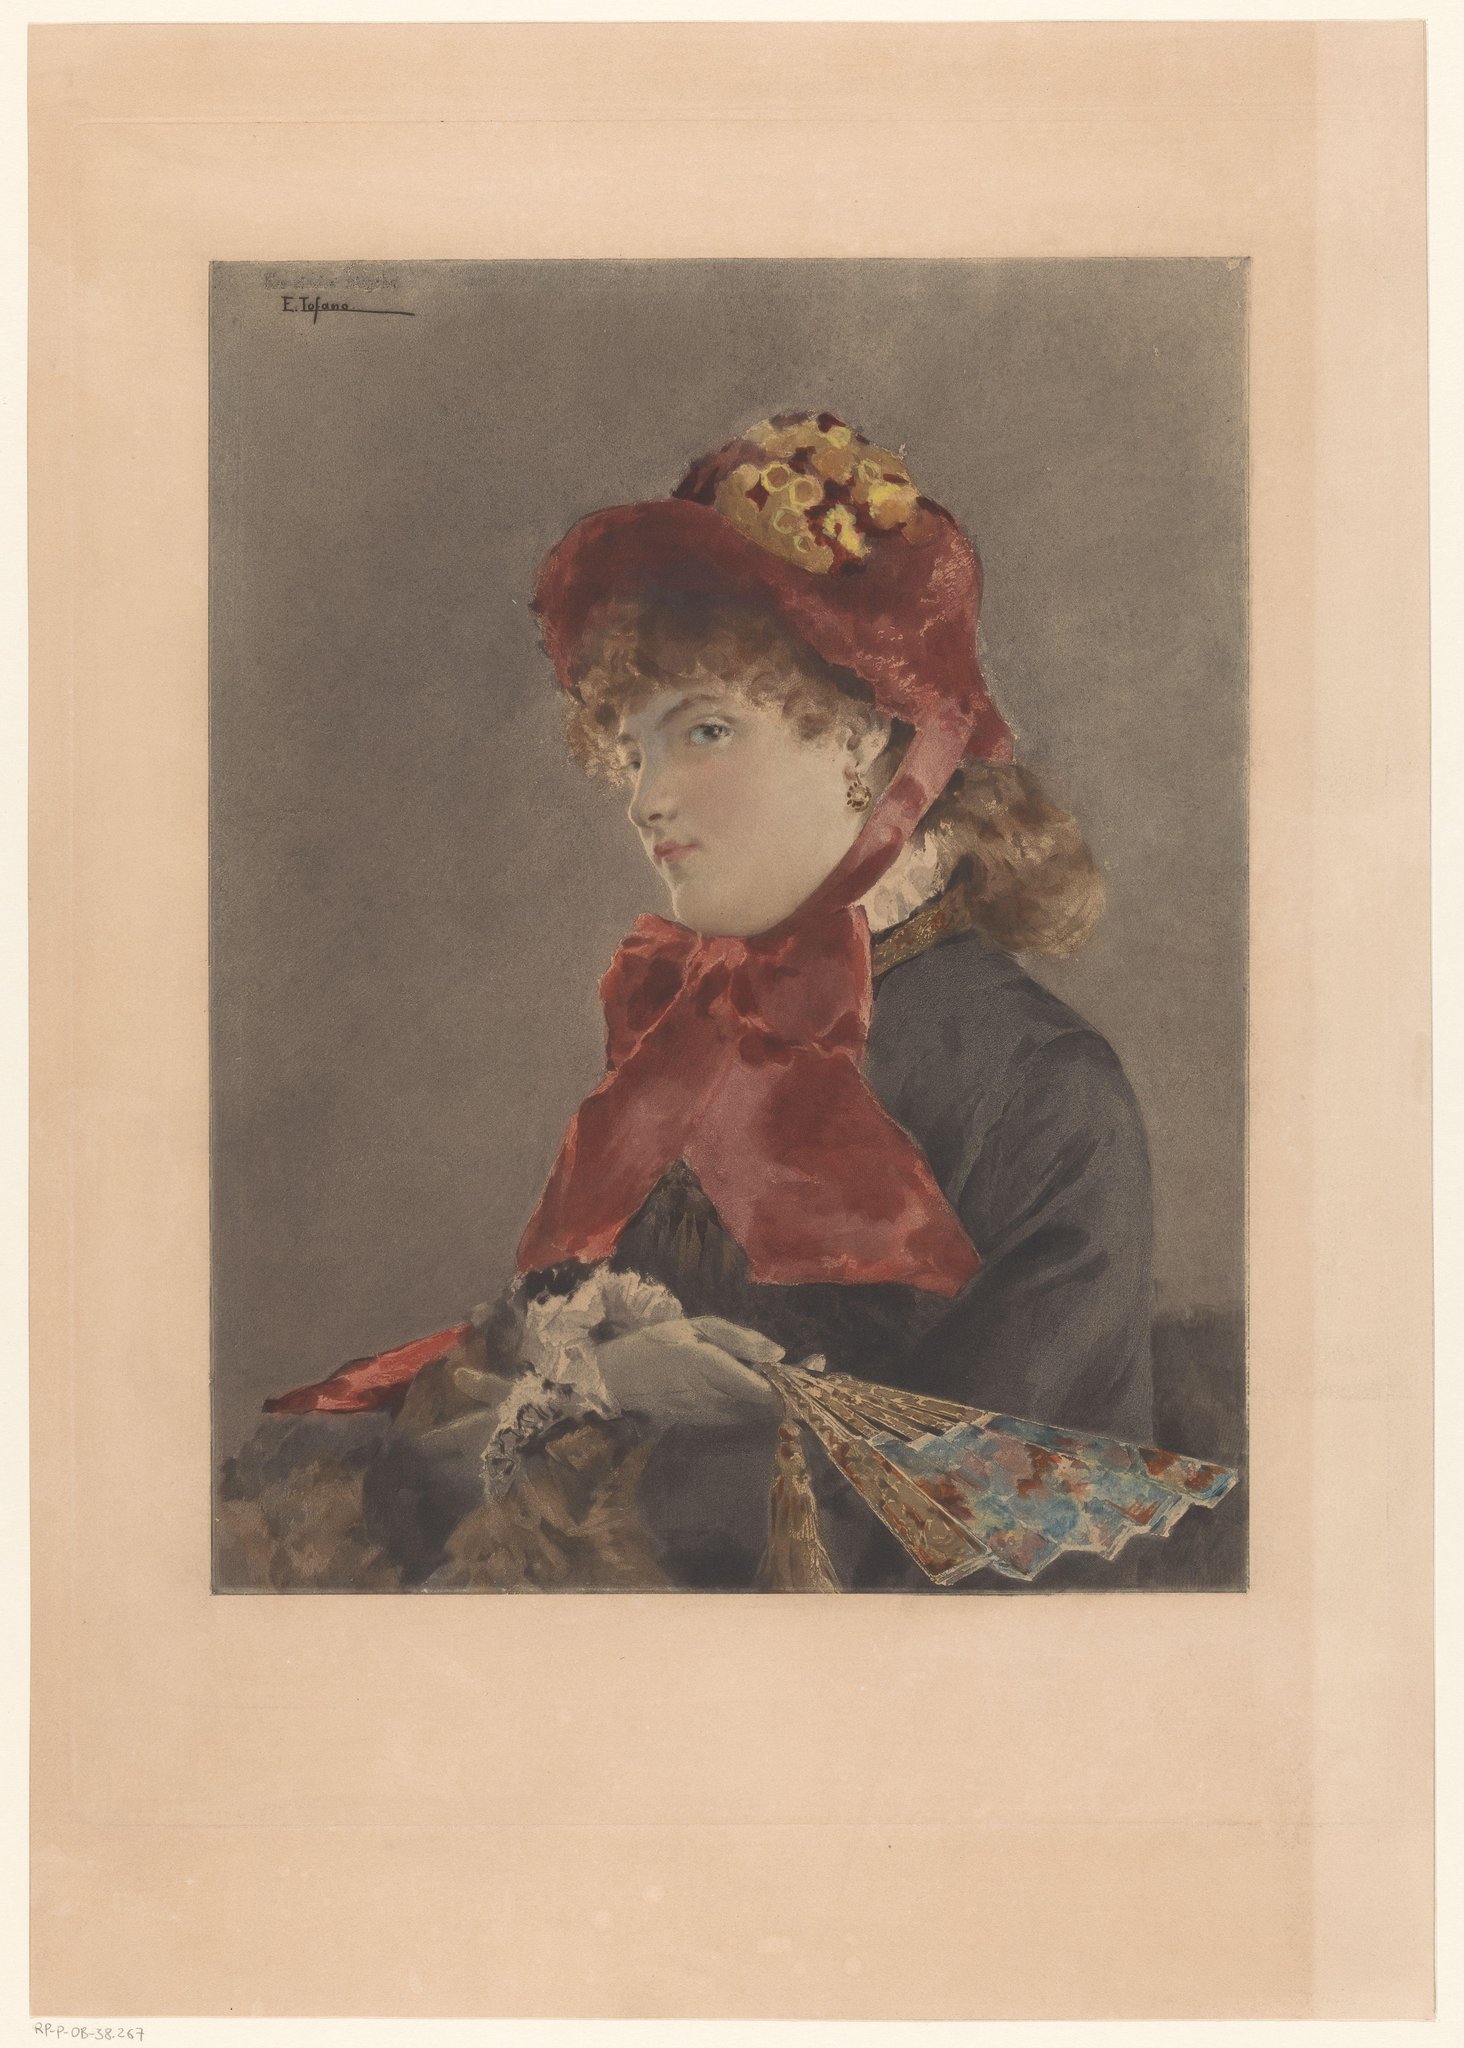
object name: print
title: Jonge vrouw met waaier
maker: eduardo tofano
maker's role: print maker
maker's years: 1838-1920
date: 1848-1920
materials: paper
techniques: hand coloring, roulette, lithography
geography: italy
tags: adolescent, young woman, maiden, fan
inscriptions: collector's mark: Lugt 2228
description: Een jonge vrouw met rood hoofddeksel, in haar hand een gekleurde waaier.